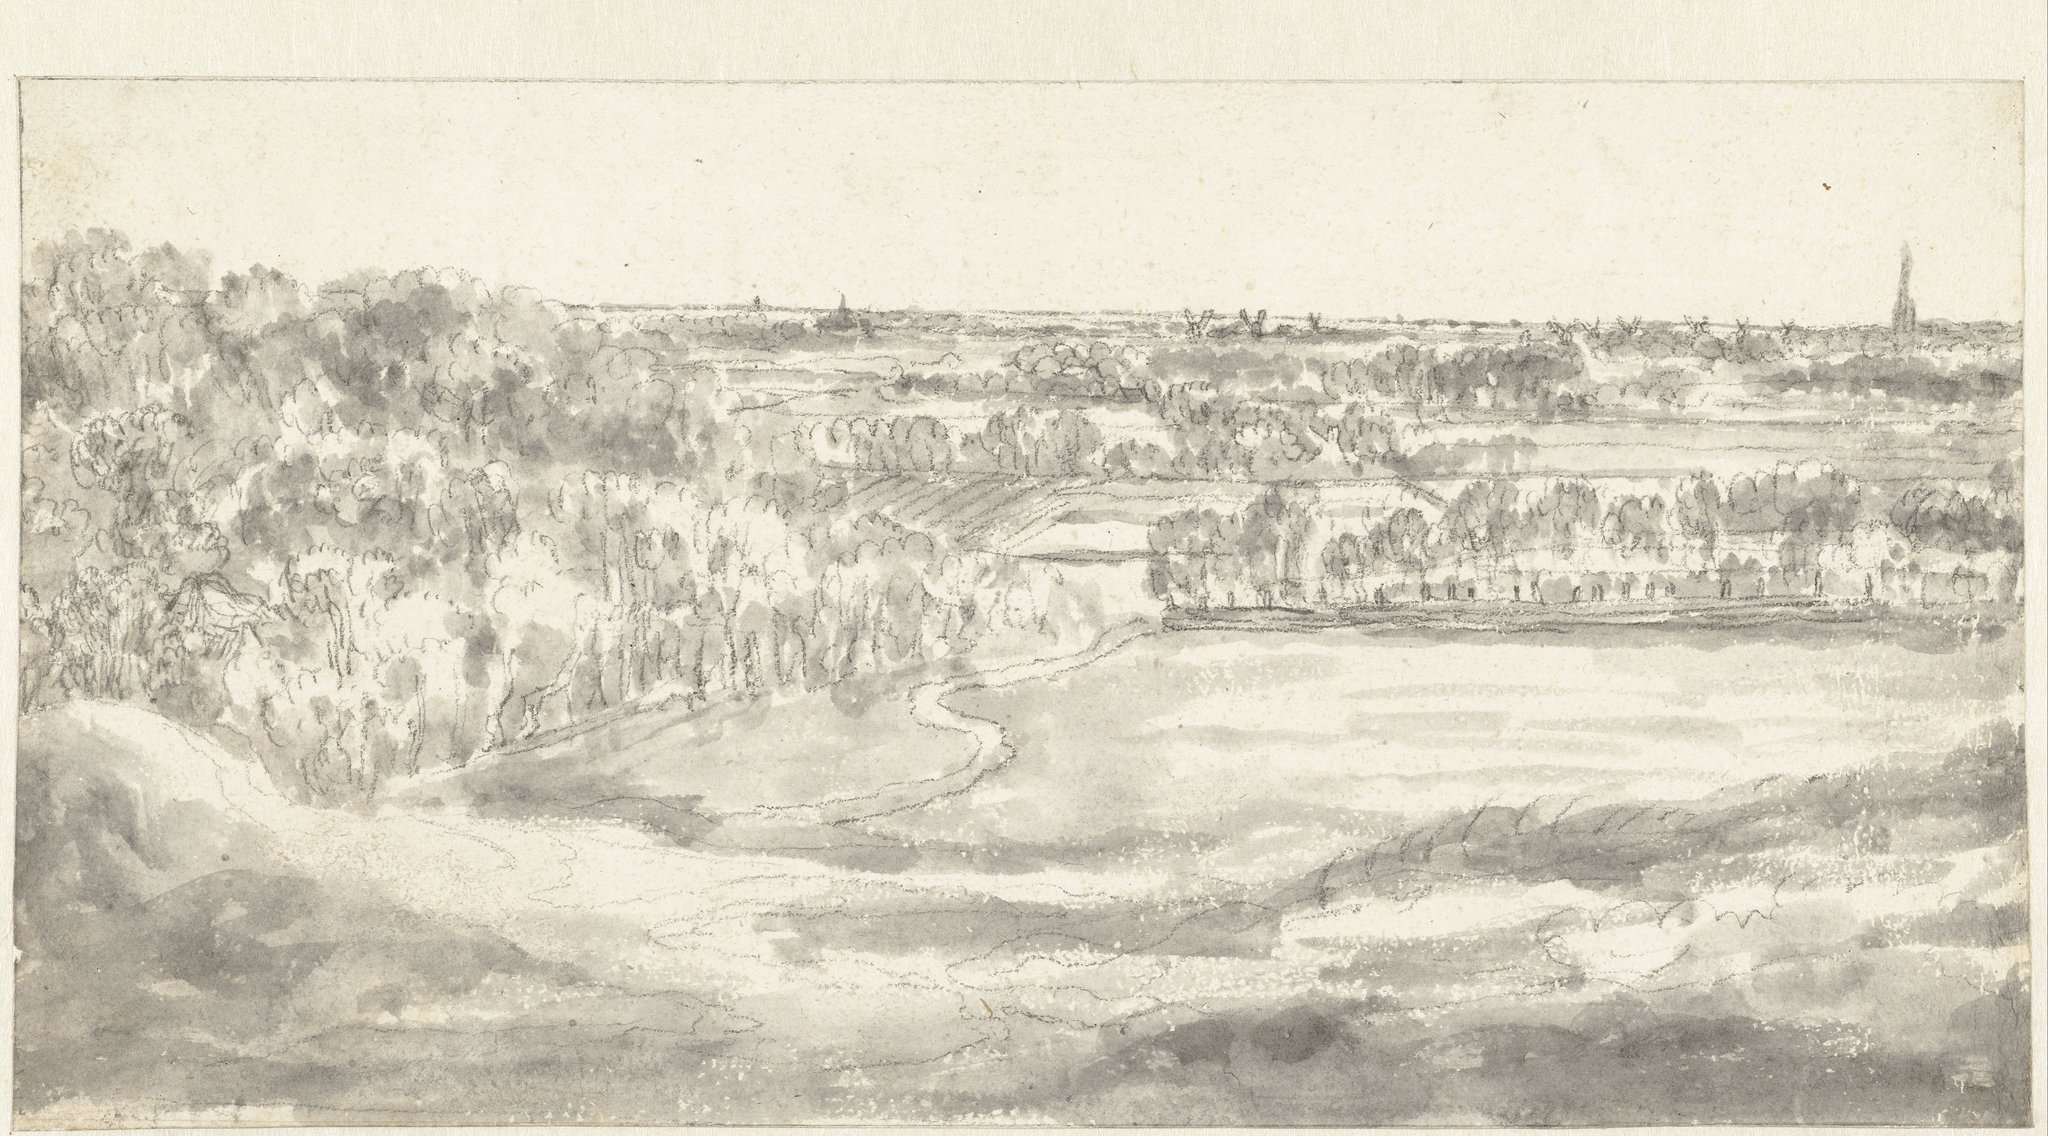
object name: drawing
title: Uitgestrekt landschap gezien vanaf een heuvel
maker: Anonymous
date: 1600-1699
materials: chalk, paper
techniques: brush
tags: city-view, and landscape with man-made constructions